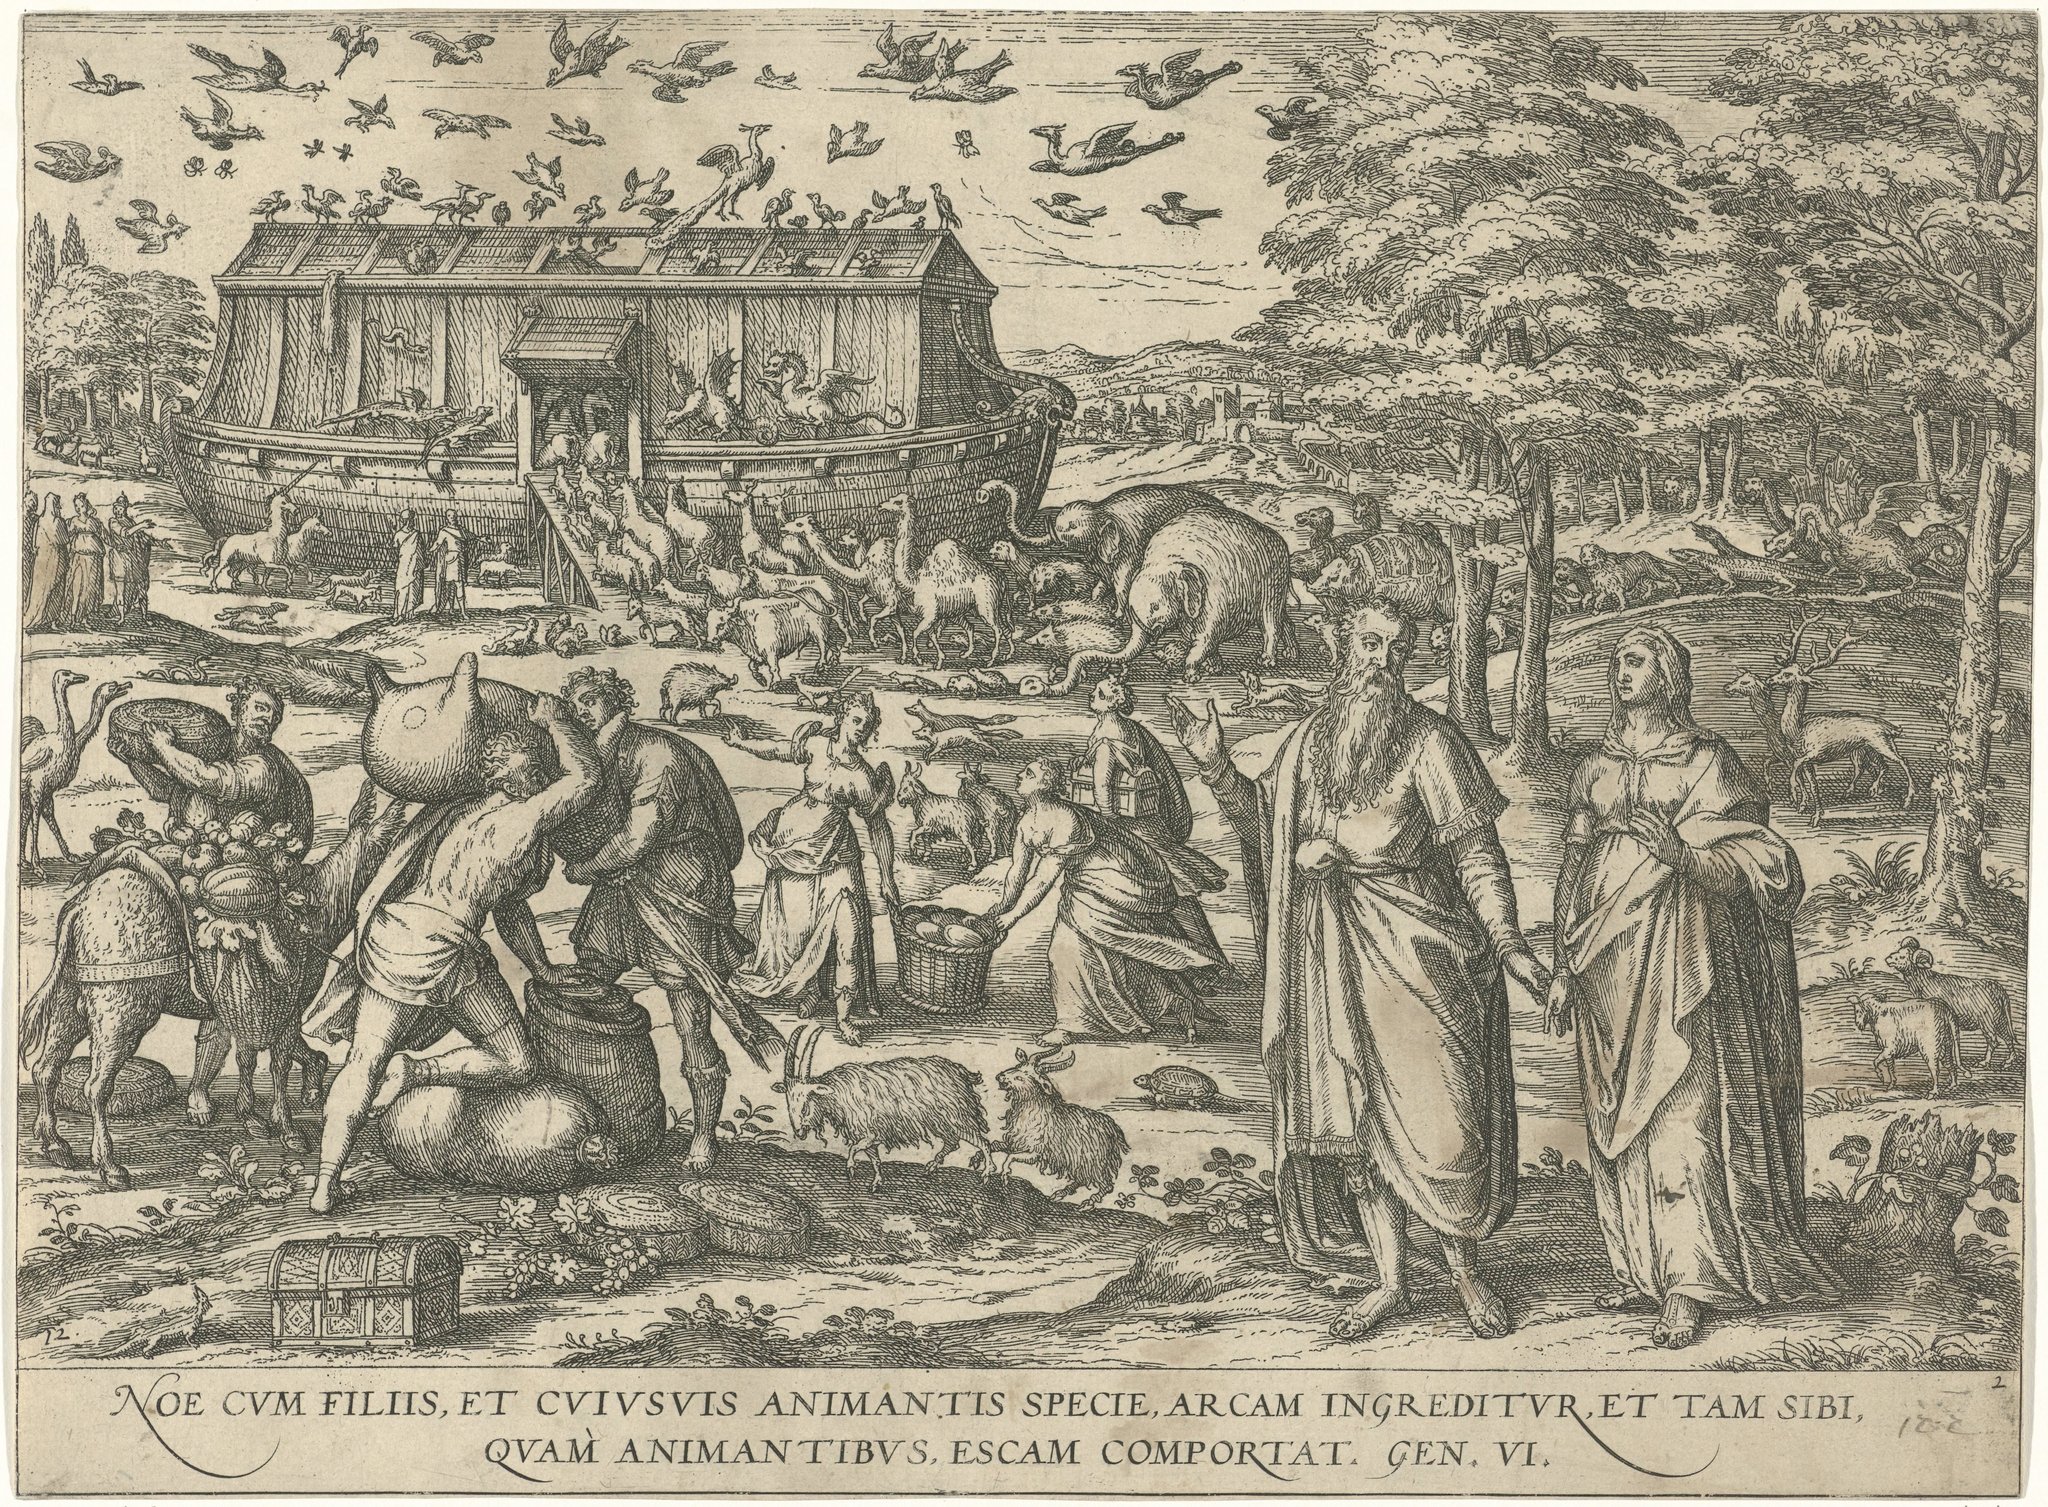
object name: print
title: Figurae et imagines bibliorum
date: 1577-1627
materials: paper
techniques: etching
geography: cologne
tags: the embarkation of the ark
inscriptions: collector's mark: Lugt 2228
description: De dieren betreden twee aan twee de ark onder toeziend oog van Noach en zijn vrouw. Links verzamelen Noachs zonen en hun vrouwen voorraden, om die aan boord te brengen. Onderaan een Bijbeltekst in het Latijn uit Gen. 6. Rechtsonder genummerd: 2.